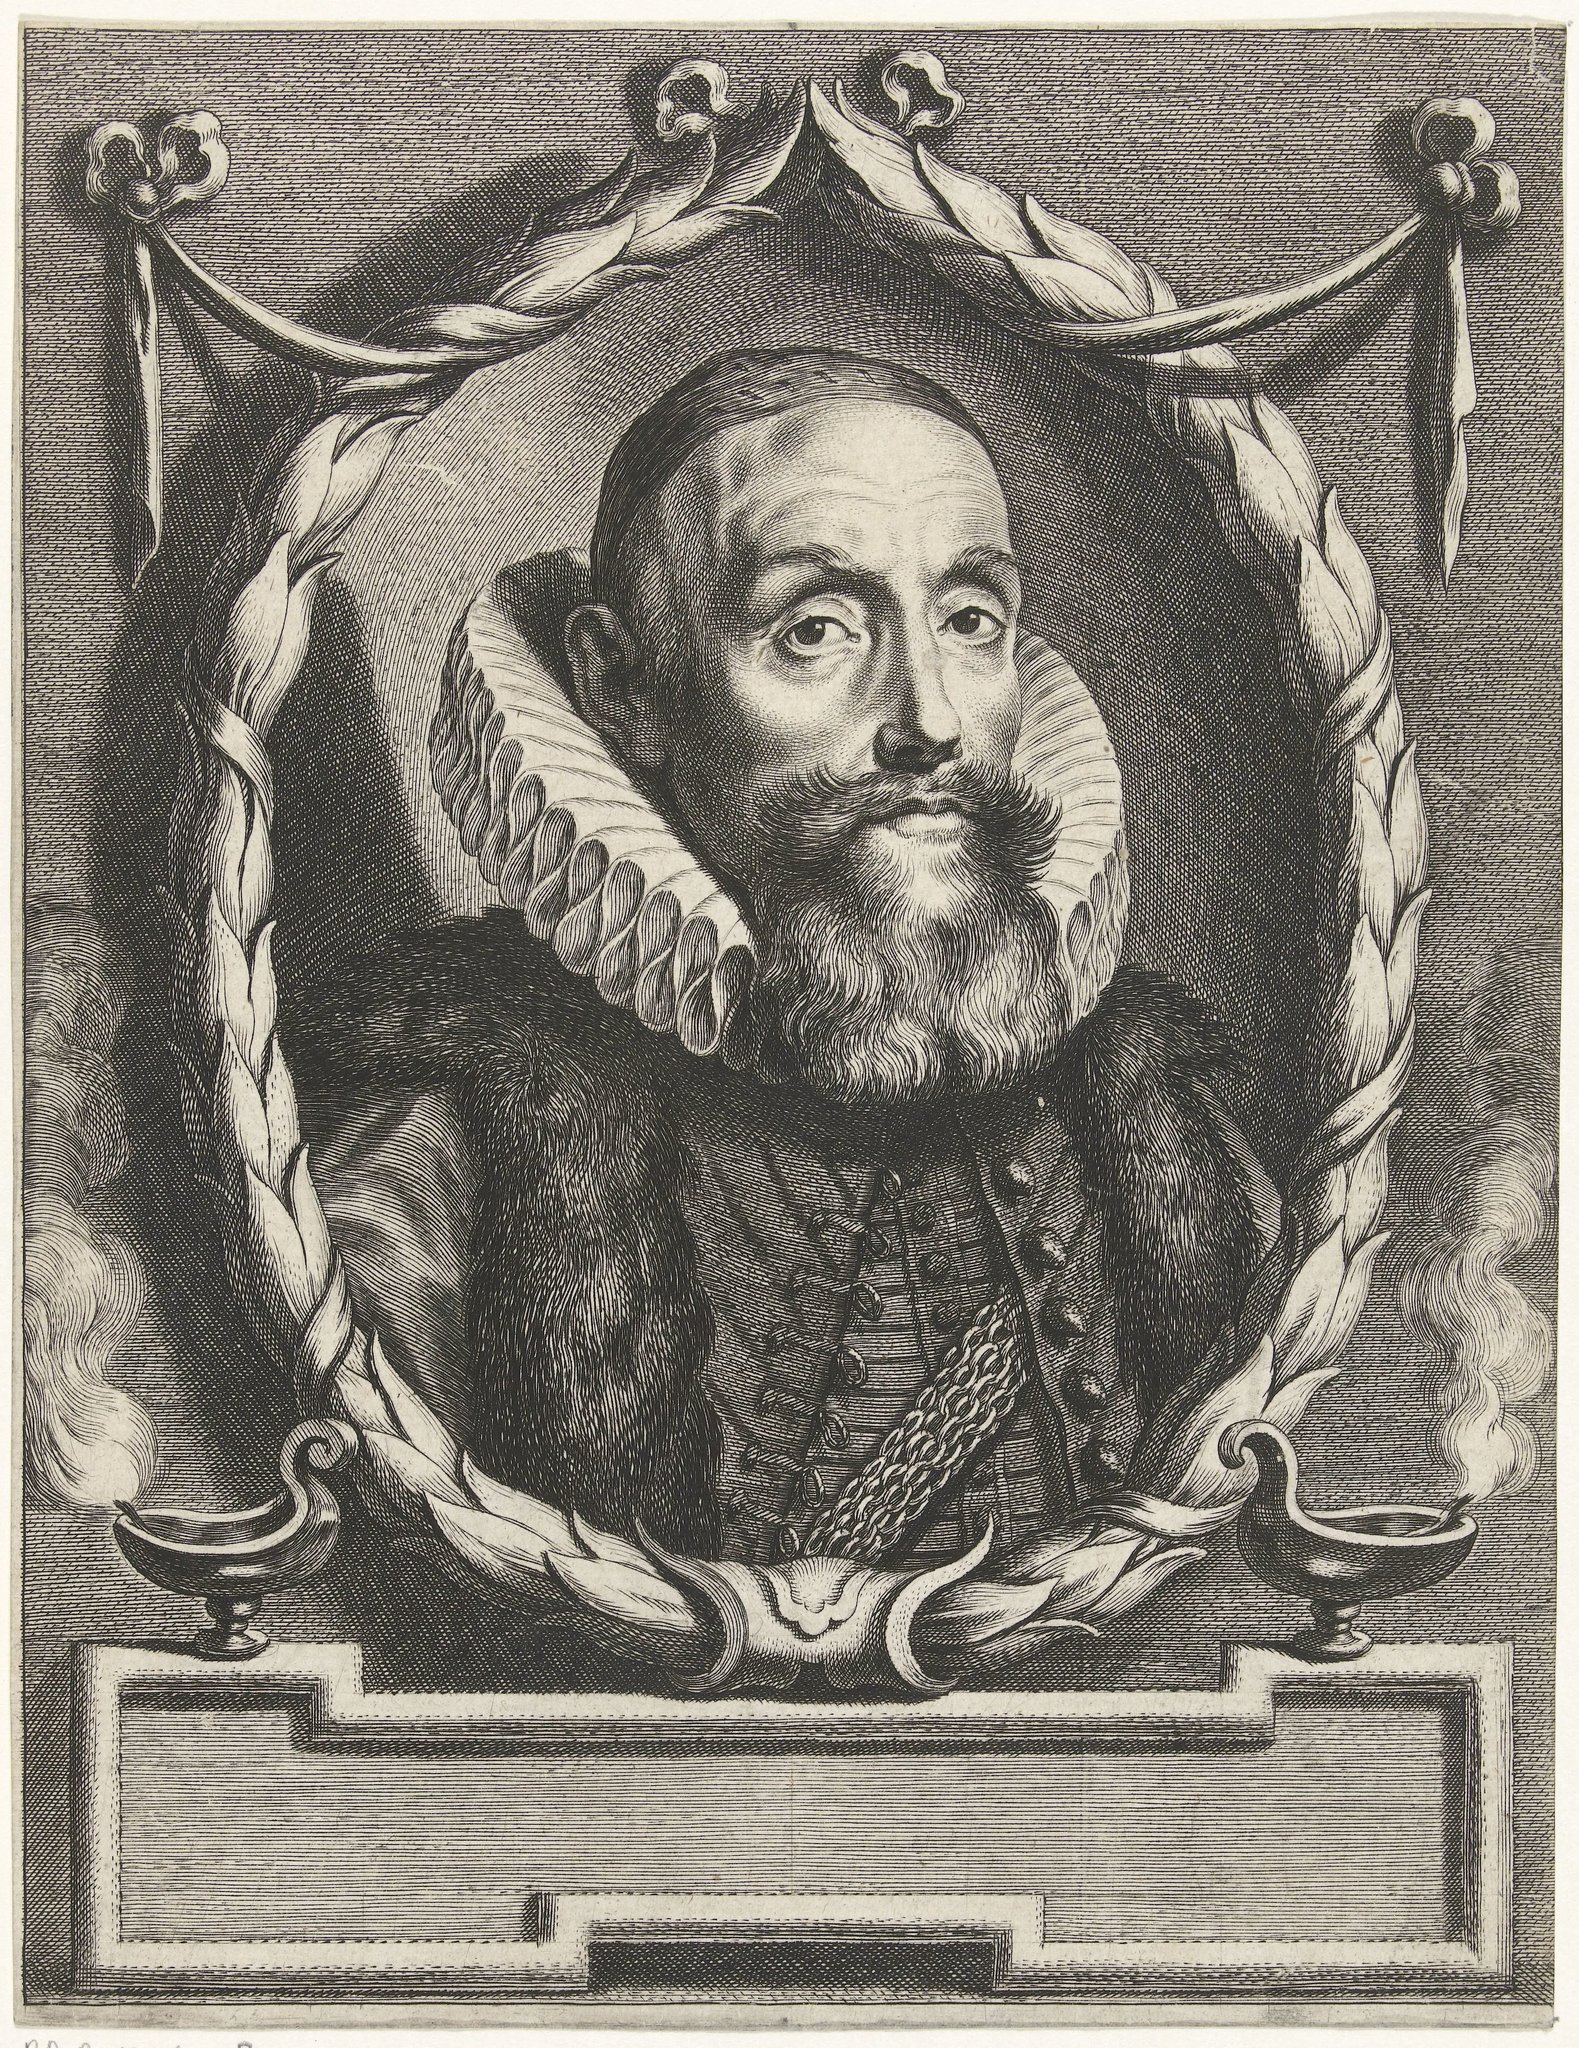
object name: print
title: Portret van Jan van Havre, heer van Walle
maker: cornelis galle (ii)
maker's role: print maker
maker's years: 1615-1678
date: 1638-1678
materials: paper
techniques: engraving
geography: southern netherlands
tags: arts, jan van havre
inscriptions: collector's mark: Lugt 2228, name: ‘E[...] Deraulx 1861’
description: Portret van Jan van Havre, heer van Walle in lauwerkrans. Aan weerszijden van het portret twee brandende olielampjes.